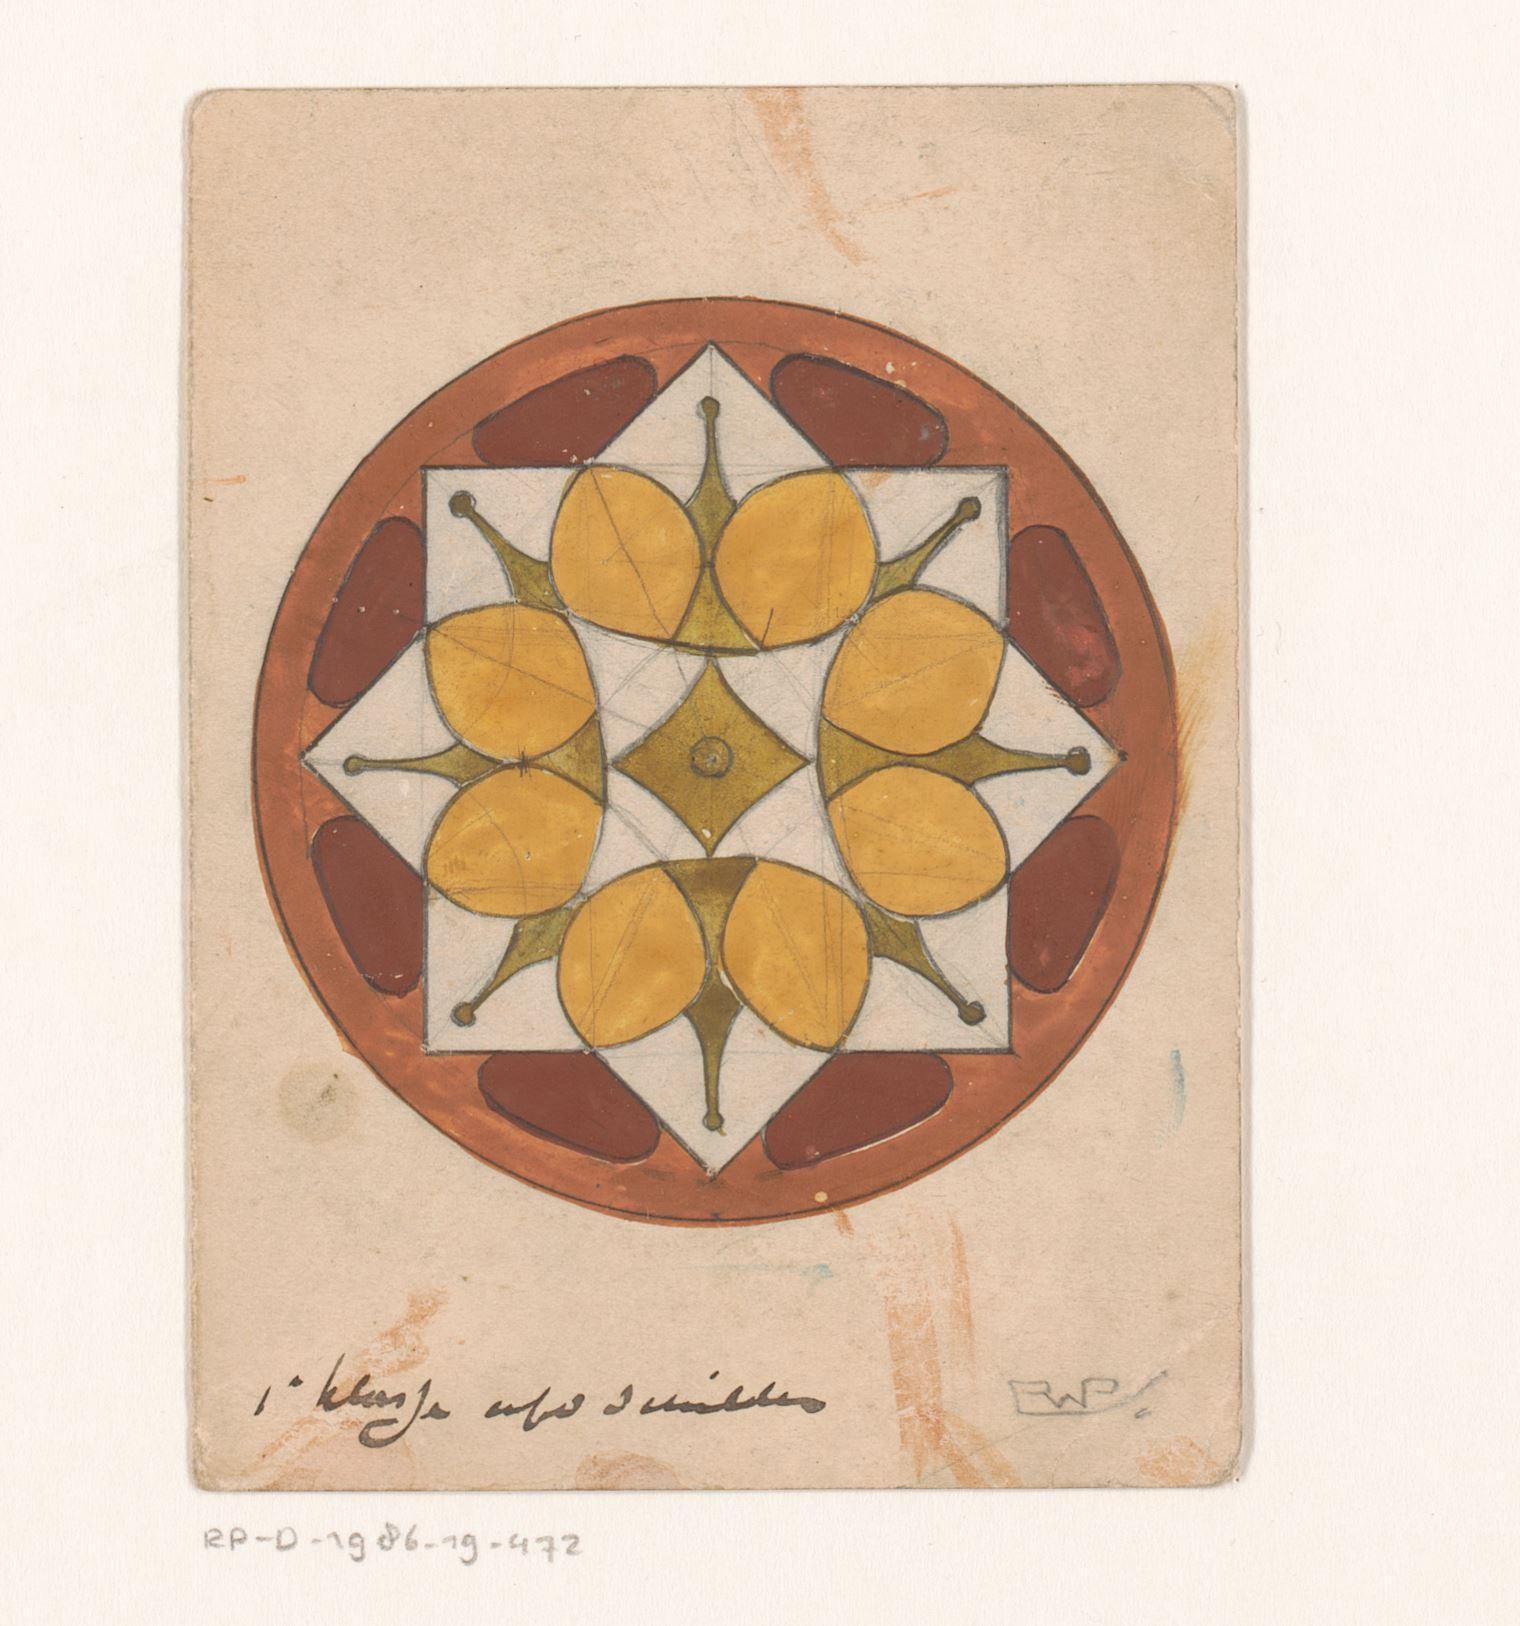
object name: drawing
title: Rond ornament met bladmotief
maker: reinier willem petrus de vries (1874-1953)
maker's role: draughtsman, print maker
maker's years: 1874-1953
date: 1884-1952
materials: paint, paper, pencil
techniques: brush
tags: ornament ~ round and curved forms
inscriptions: collector's mark: ‘R:MVS.’, name: ‘R.W.P. Jr’, annotation: ‘1e klusje [...]’